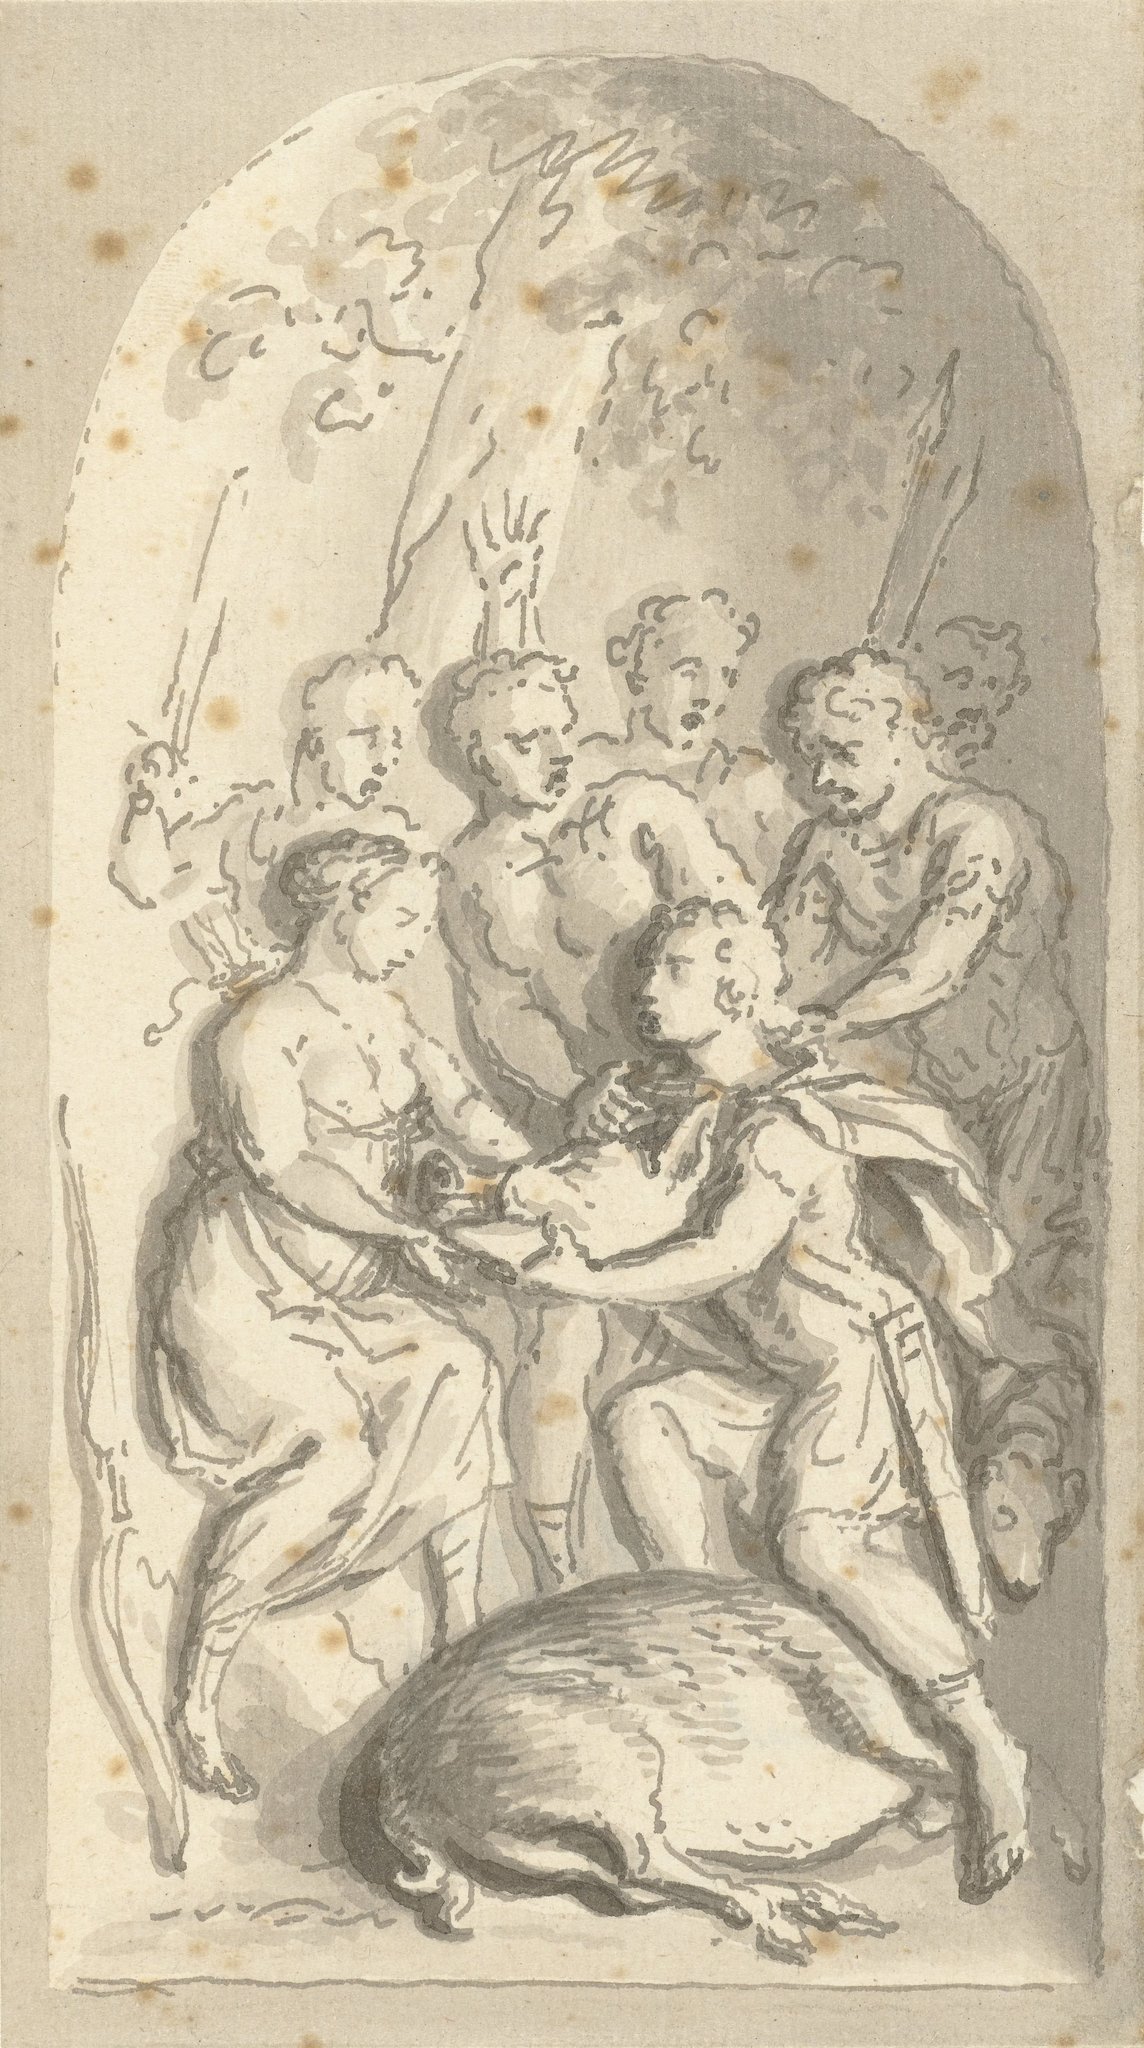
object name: drawing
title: Meleager brengt Atalante het hoofd van het Calydonische zwijn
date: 1712-1795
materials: ink, paper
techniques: brush, pen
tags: meleager gives the head of the boar to atalanta